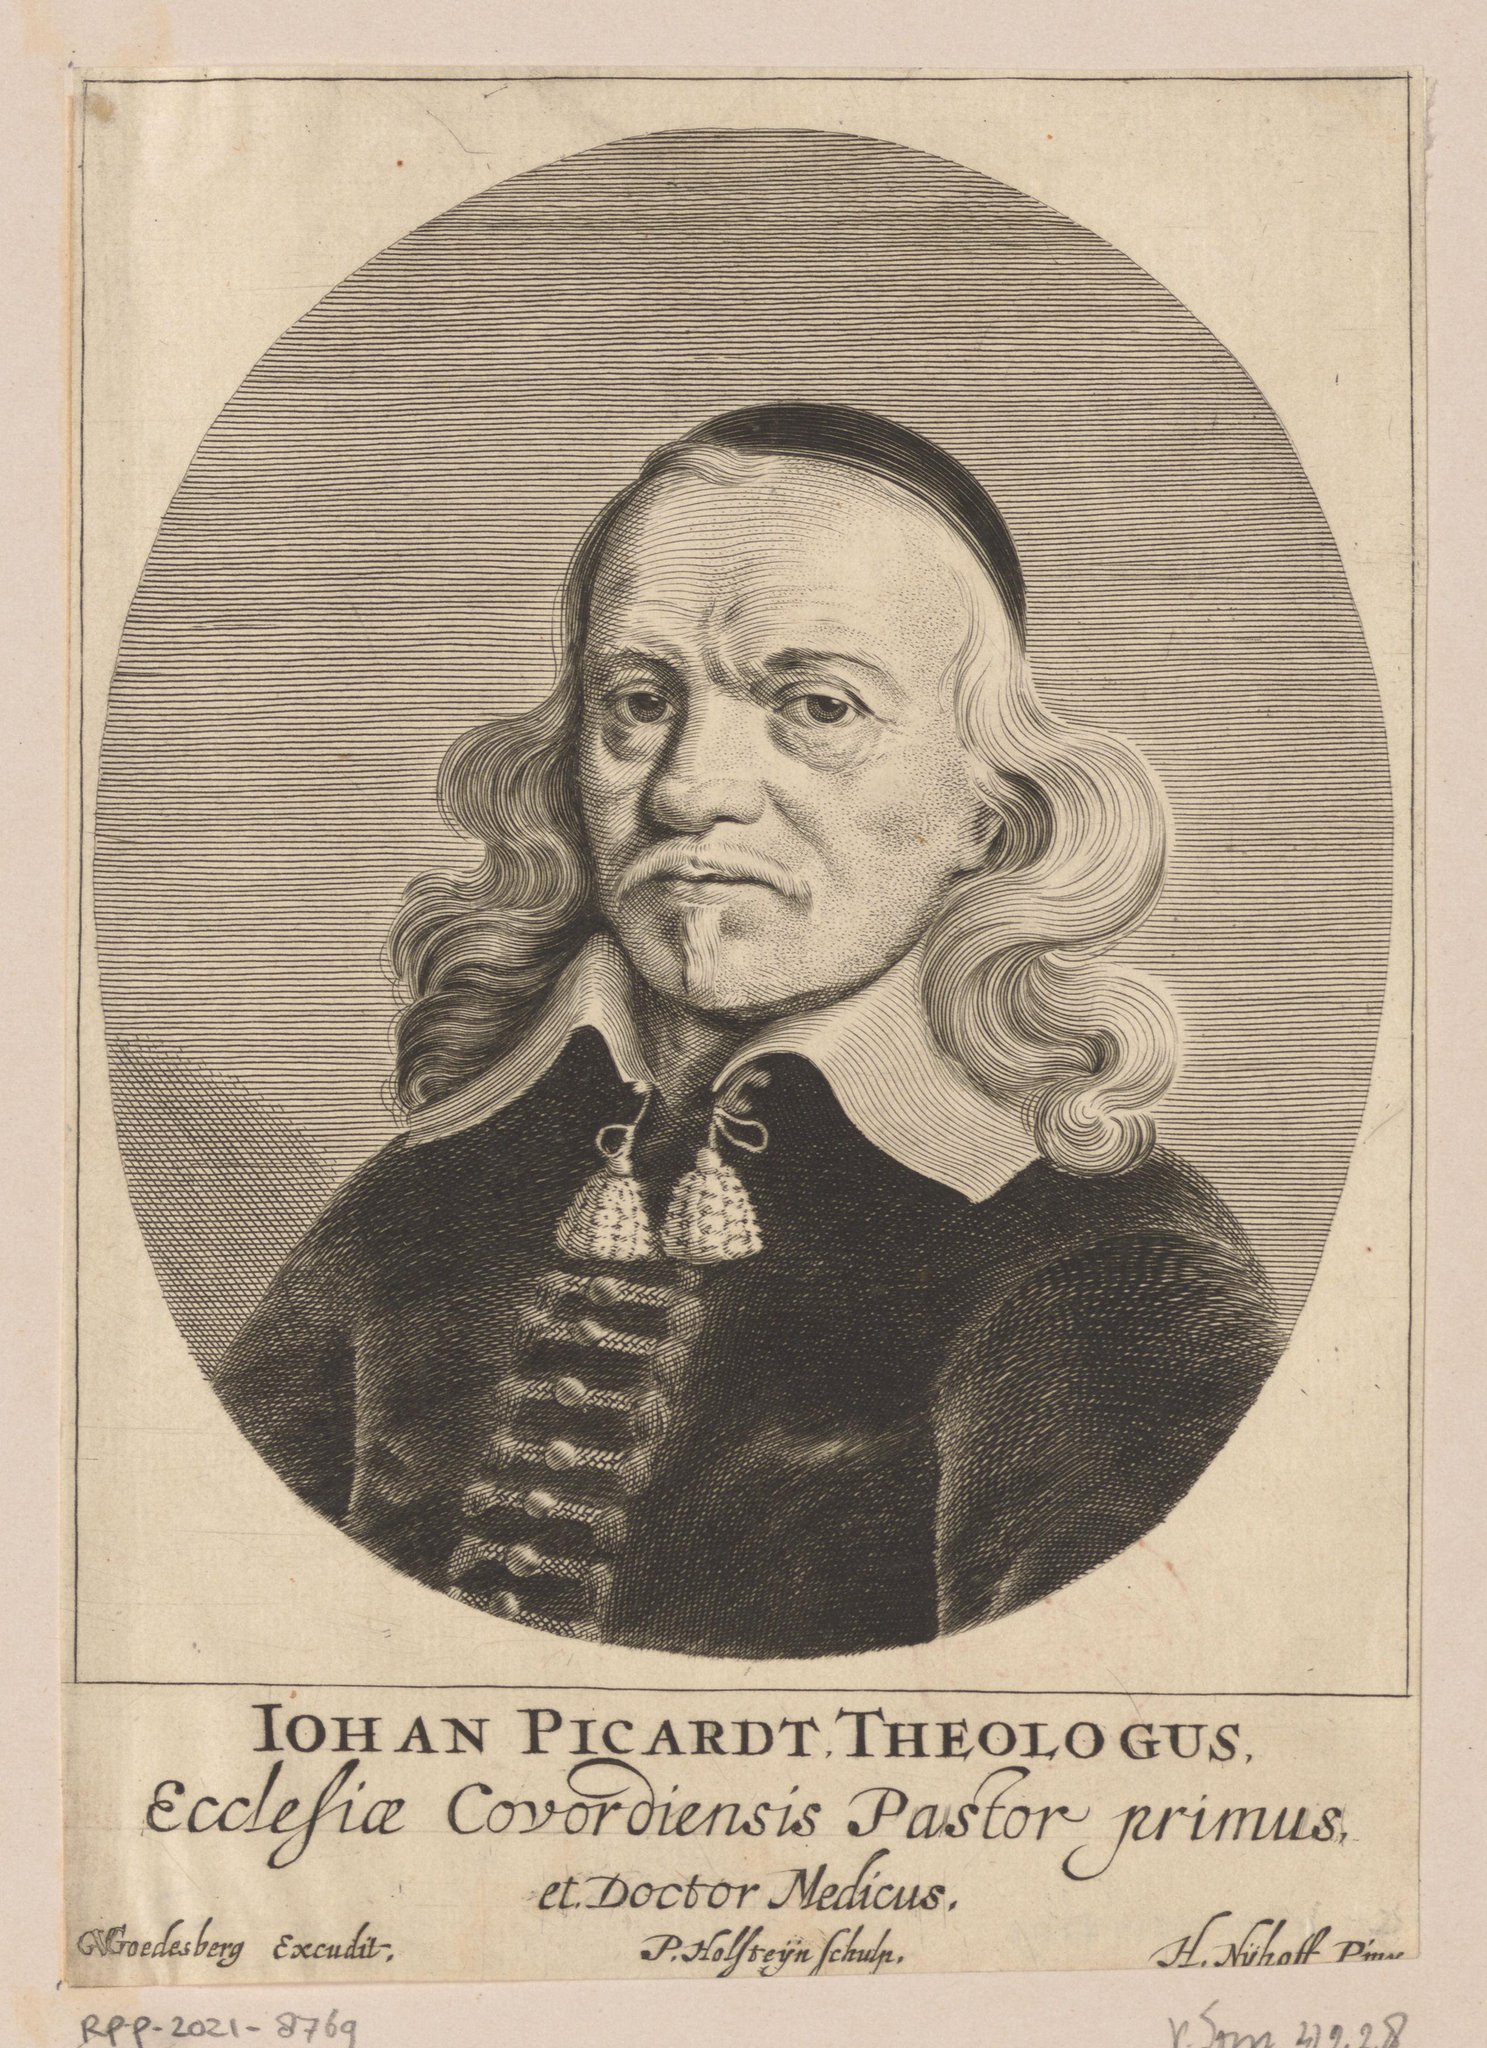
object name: print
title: Portret van Johan Picardt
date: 1660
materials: paper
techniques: engraving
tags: johan picardt, adult man, historical persons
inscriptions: collector's mark: Lugt 240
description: Prent mogelijk uit: Picardt, Johan. Korte beschryvinge van eenige vergetene en verborgene Antiquiteten der provintien en Landen gelegen tusschen de Noord-Zee, de Yssel, Emse en Lippe. Amsterdam: Goedesberg, 1660.